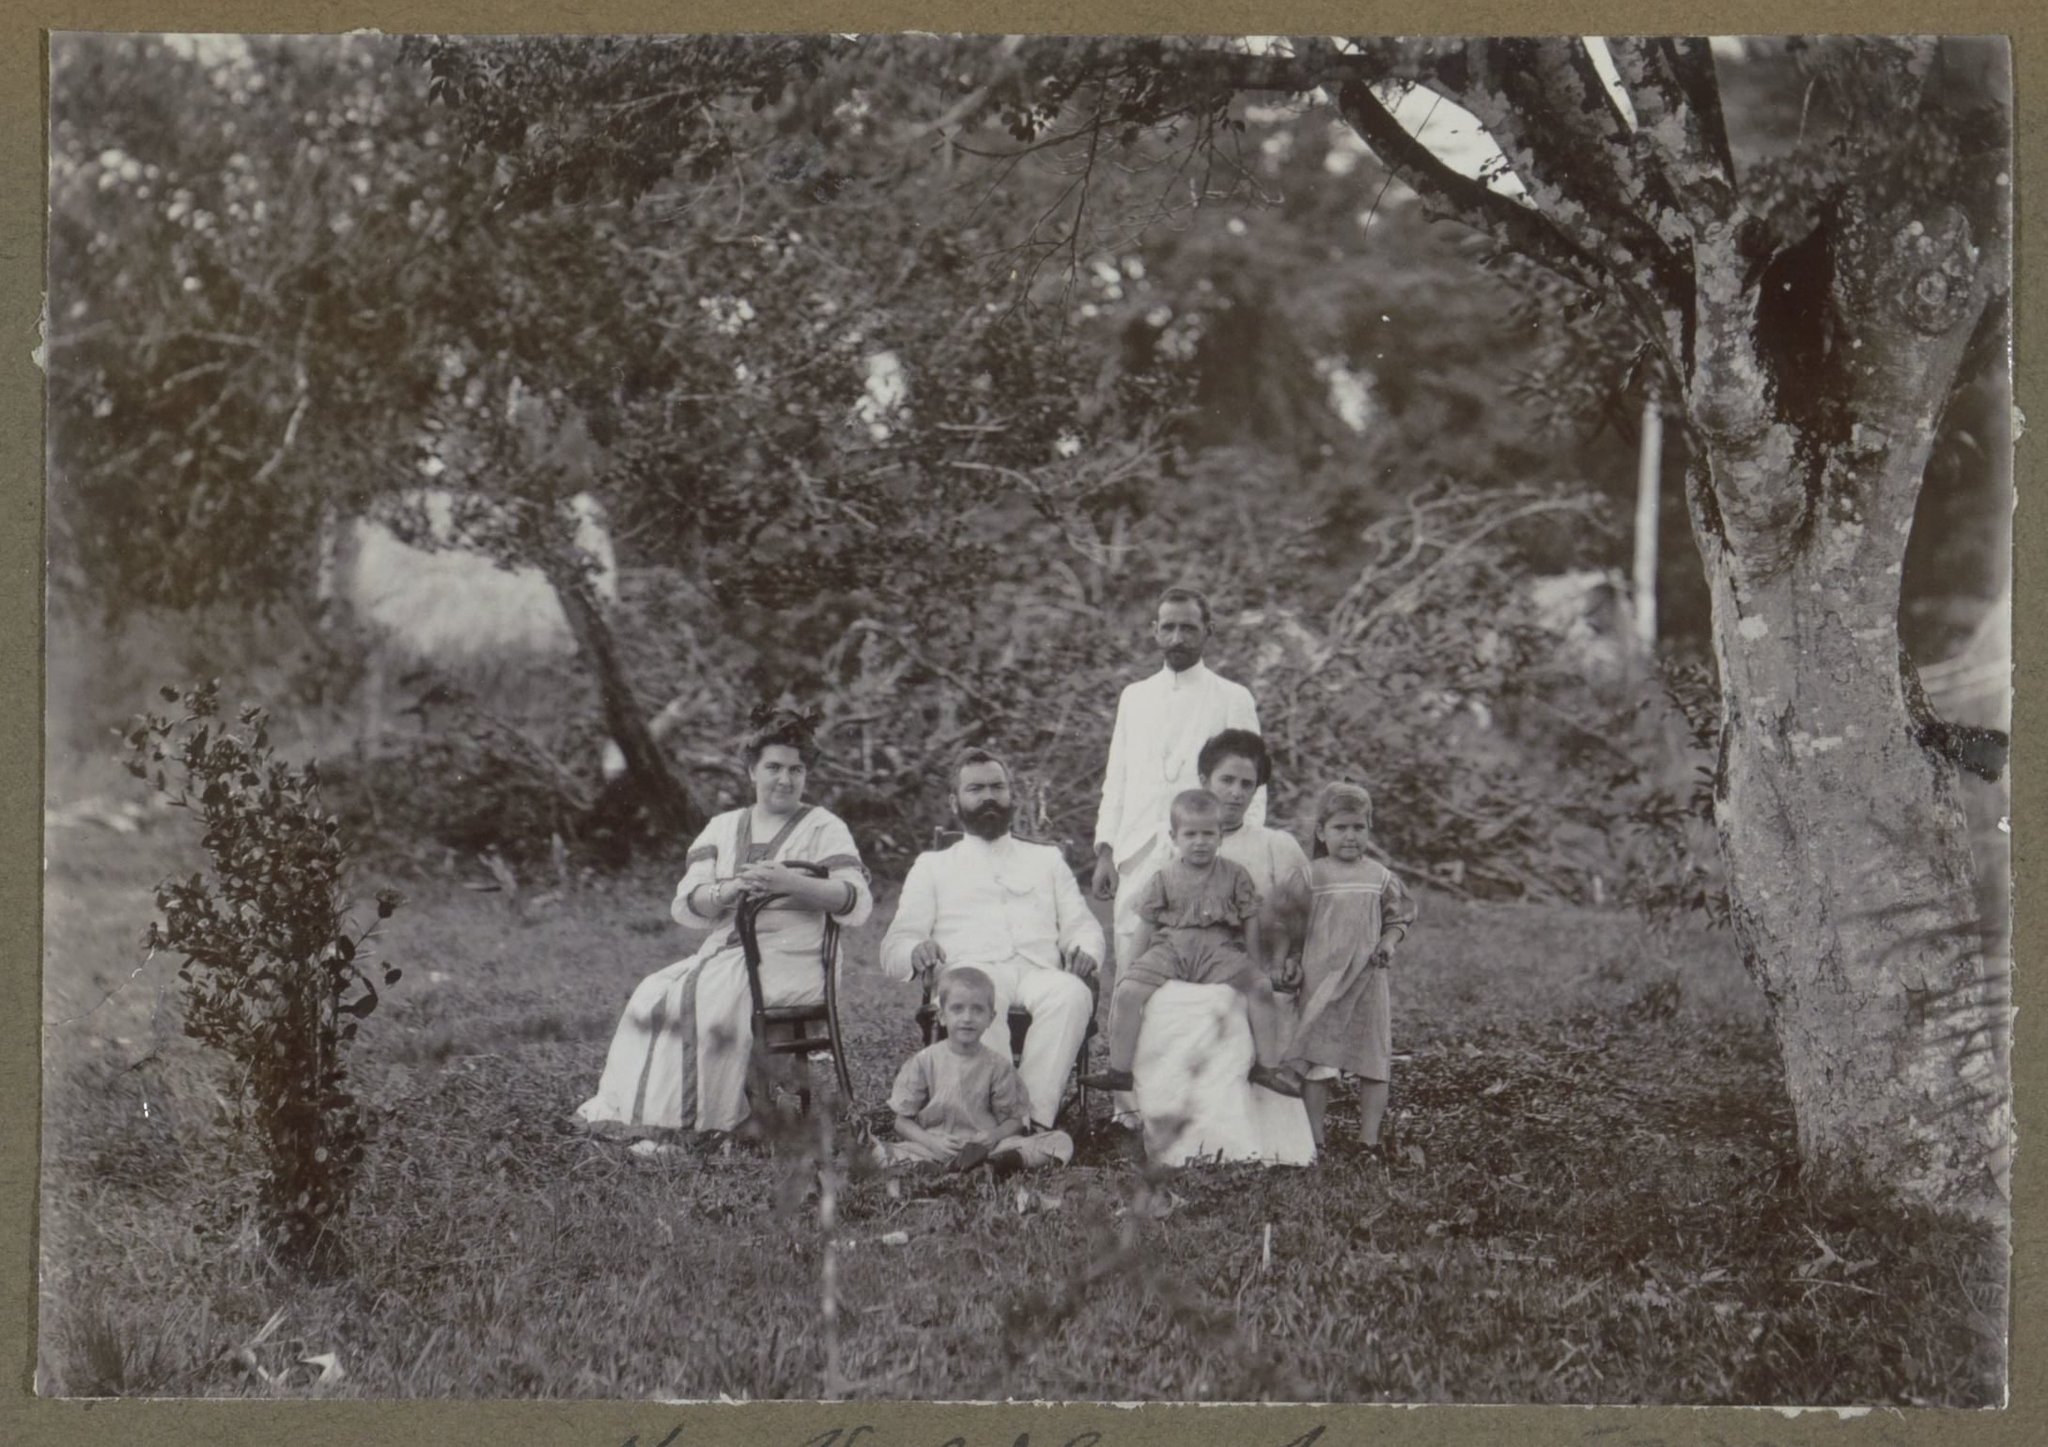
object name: photograph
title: Gezelschap met drie kinderen in een tuin, mogelijk op buitenplaats 'Veldlust' in Suriname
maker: Anonymous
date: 1920-1930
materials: photographic support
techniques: gelatin silver print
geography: suriname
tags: family group, especially parents with their child(ren), suriname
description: Onderdeel van fotoalbum van een onbekende Nederlandse familie met opnames van Suriname, Europa en Nederlands-Indië.